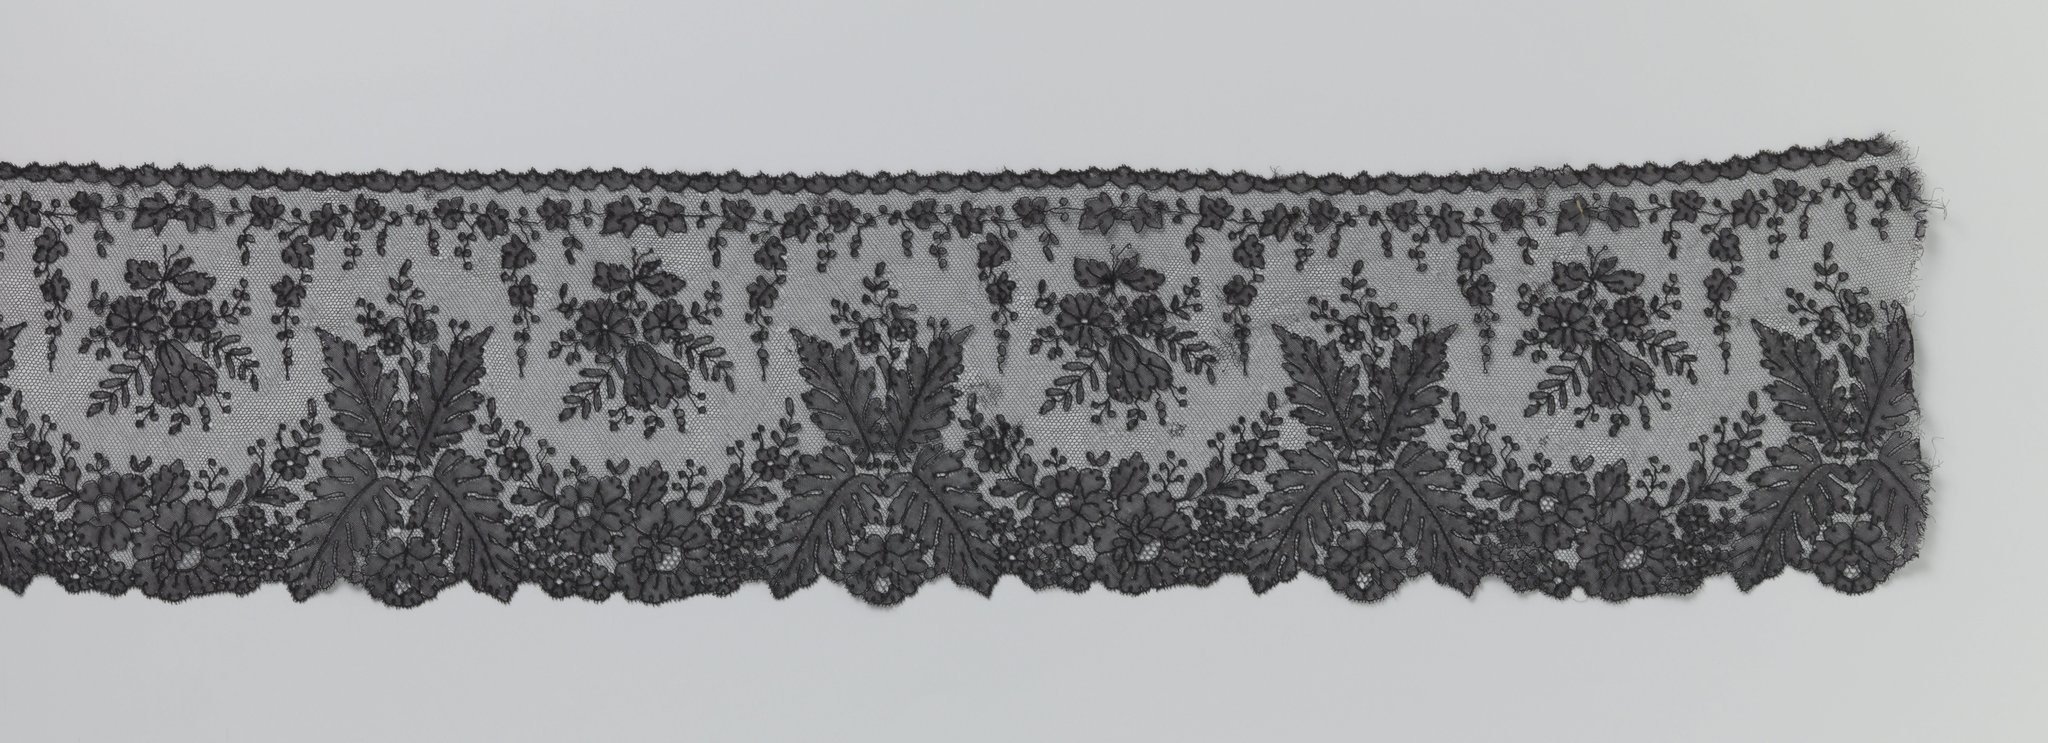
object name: strip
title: Japonstrook van kloskant met varens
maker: Anonymous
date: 1850-1855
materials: silk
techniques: lace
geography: france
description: Japonstrook van zwarte kloskant: Chantilly-kant. Op een leeg mazenfond staat een gesloten rand met schulpen, gevuld met een guirlande van bloemen en bladeren. Op de snijpunten staat een kleine schulp met een hangende roos, waarboven een spits boeket oprijst van vier grote varenbladeren en een bloemtak, die tot aan de bovenrand reikt. Hier loopt een horizontale klimoprank met hangende takjes, terwijl op het veld boven de grote schulp van deze klimoprank een groot boeket afhangt, onder andere met een tulp.